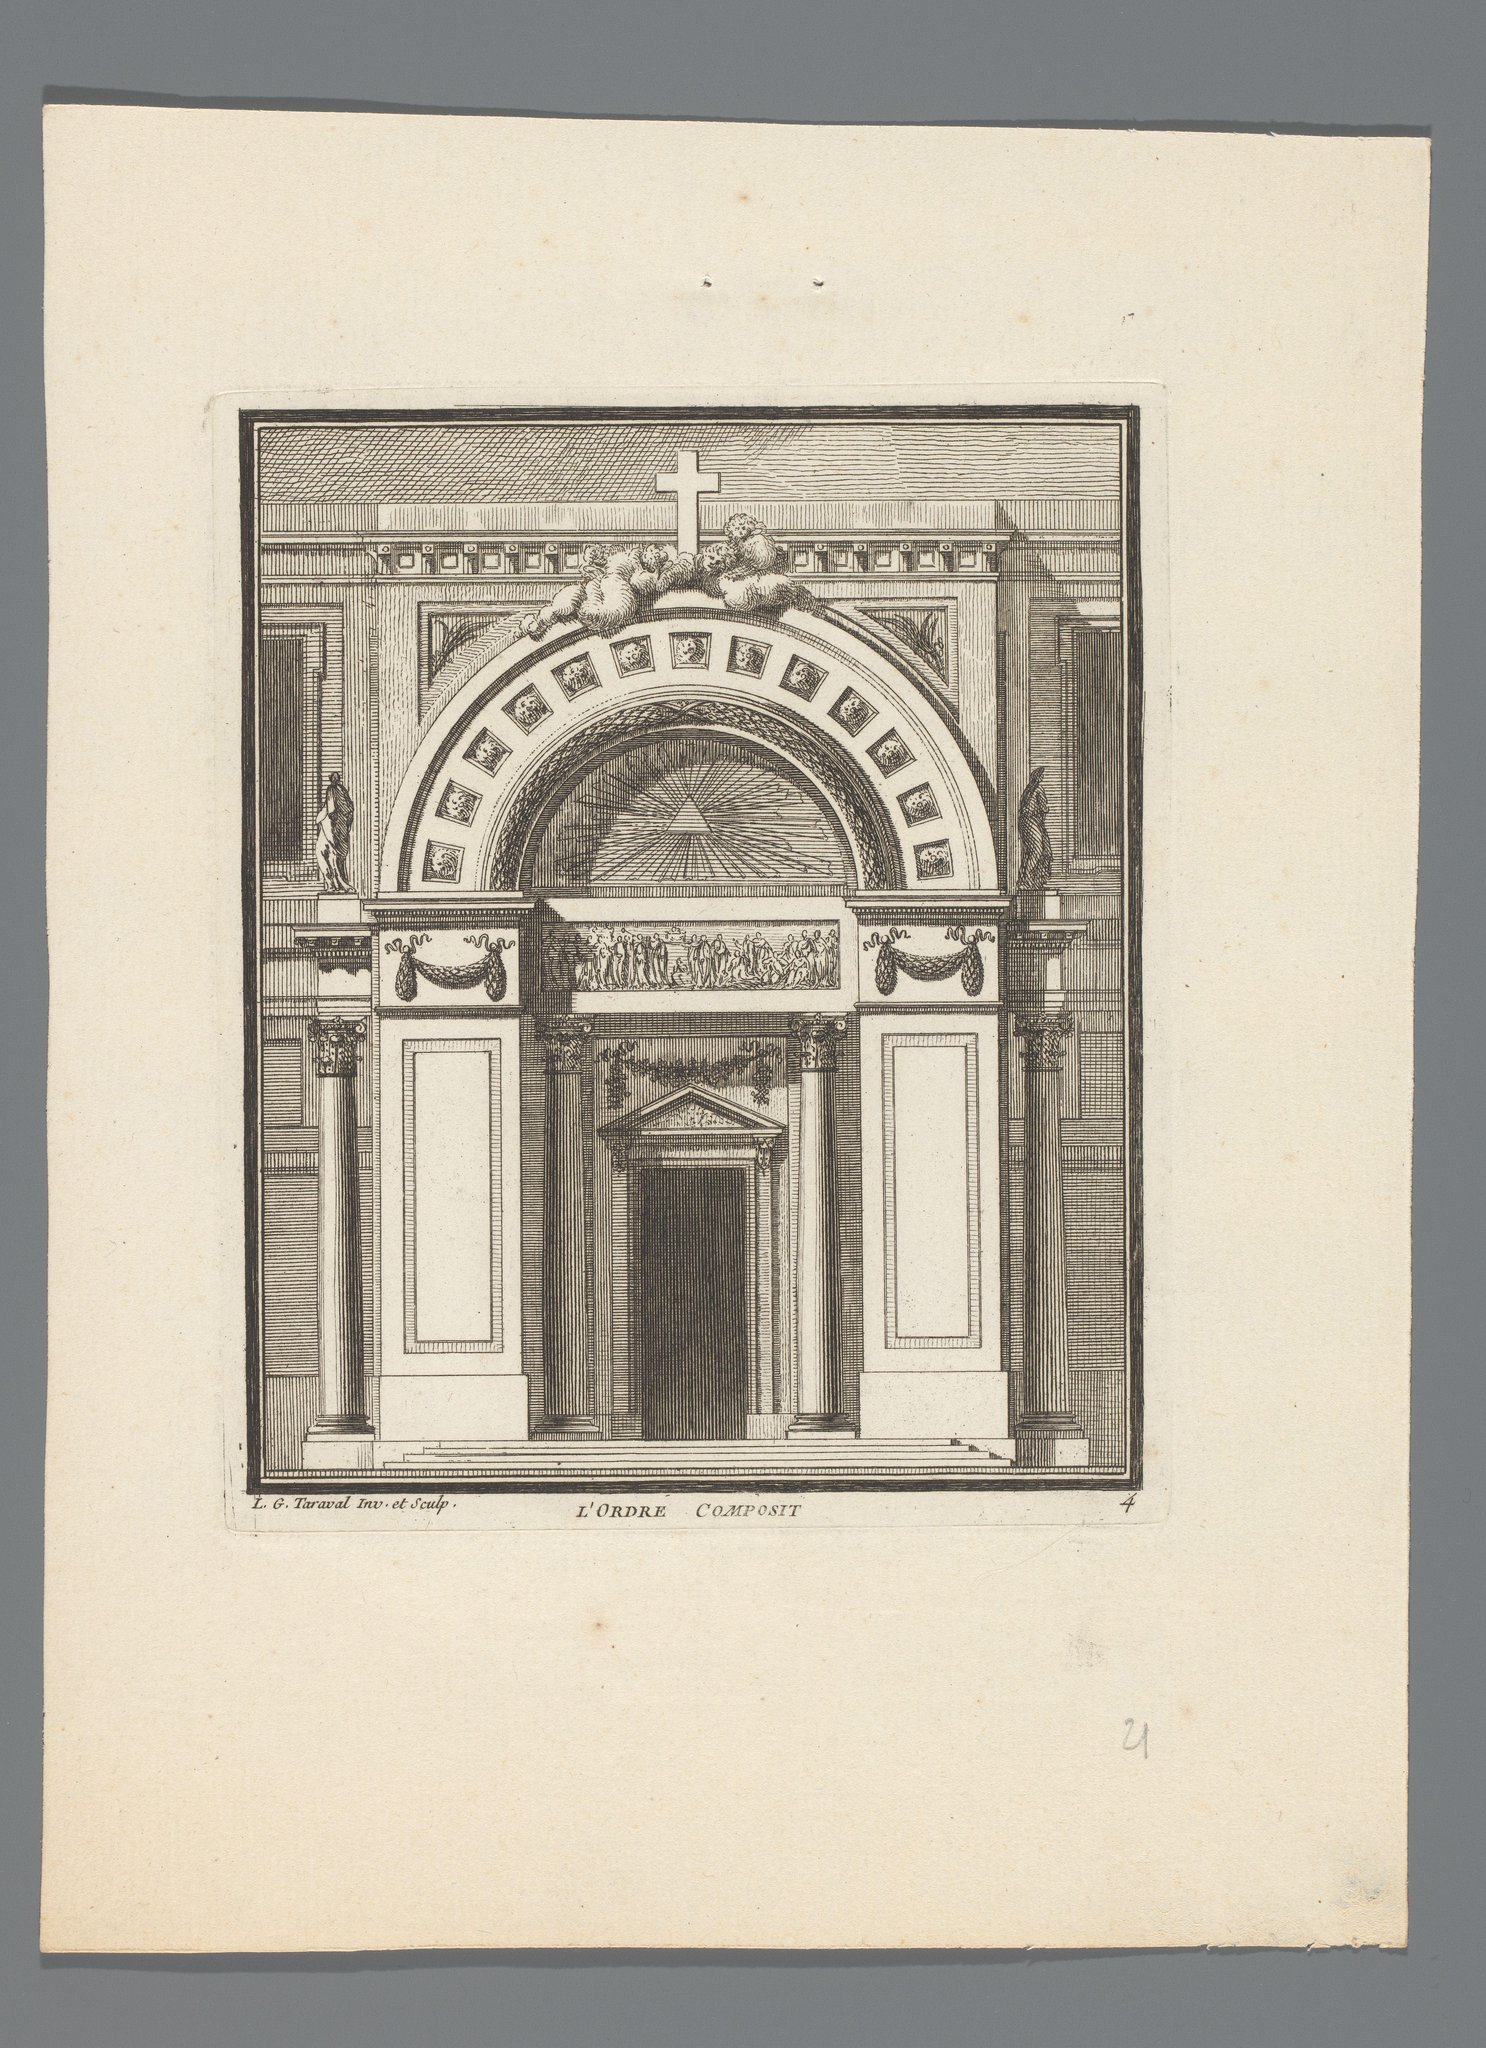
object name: print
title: Composiet portaal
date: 1768-1786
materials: paper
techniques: etching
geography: paris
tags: monumental door, porch, 'aediculum', composite order ~ architecture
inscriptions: collector's mark: Lugt 2760, collector's mark: Lugt 2228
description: Een portaal met Composiete zuilen, een fries met figuren en een rondboog met een driehoek in stralenkrans. Aan de bovenzijde een kruis omgeven door wolken en puttihoofden.